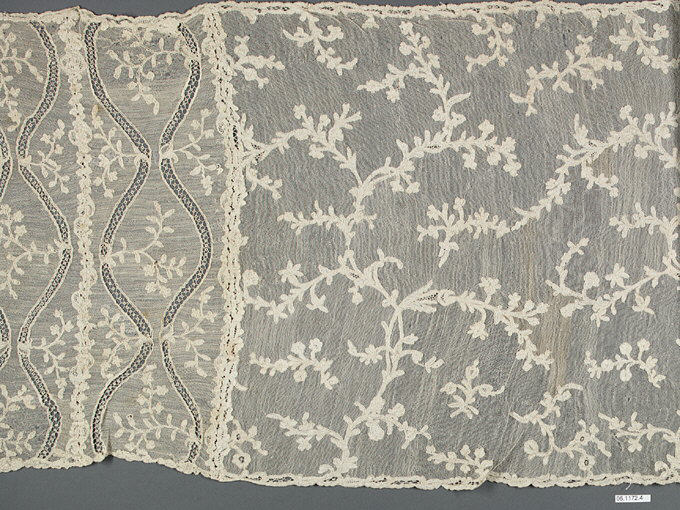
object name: scarf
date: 1701-1800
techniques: lace